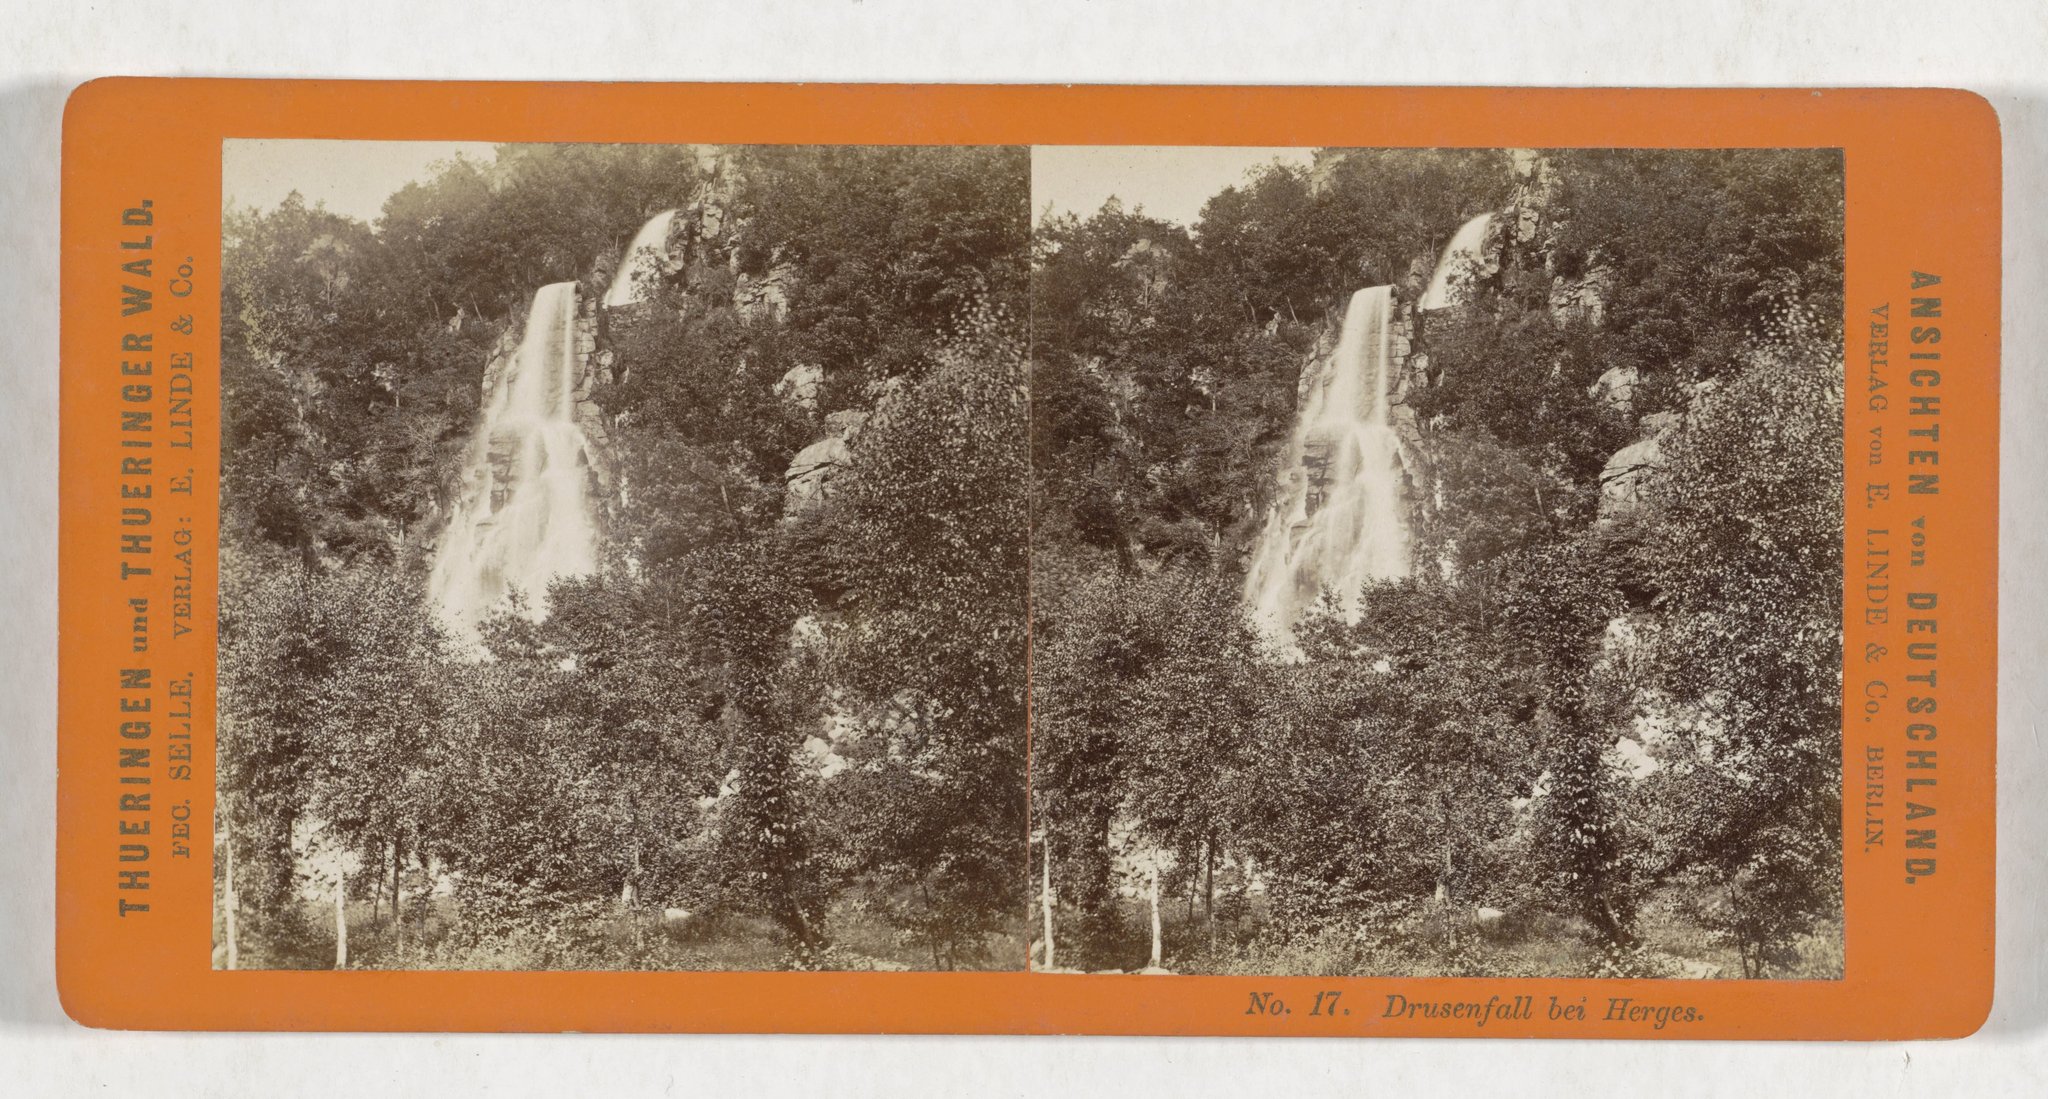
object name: stereograph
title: Trusetaler waterval nabij Herges-Vogtei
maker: hermann selle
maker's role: fotograaf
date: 1868-1890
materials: cardboard, paper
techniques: albumen print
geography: berlin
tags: waterfall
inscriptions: number: ‘No. 17.’